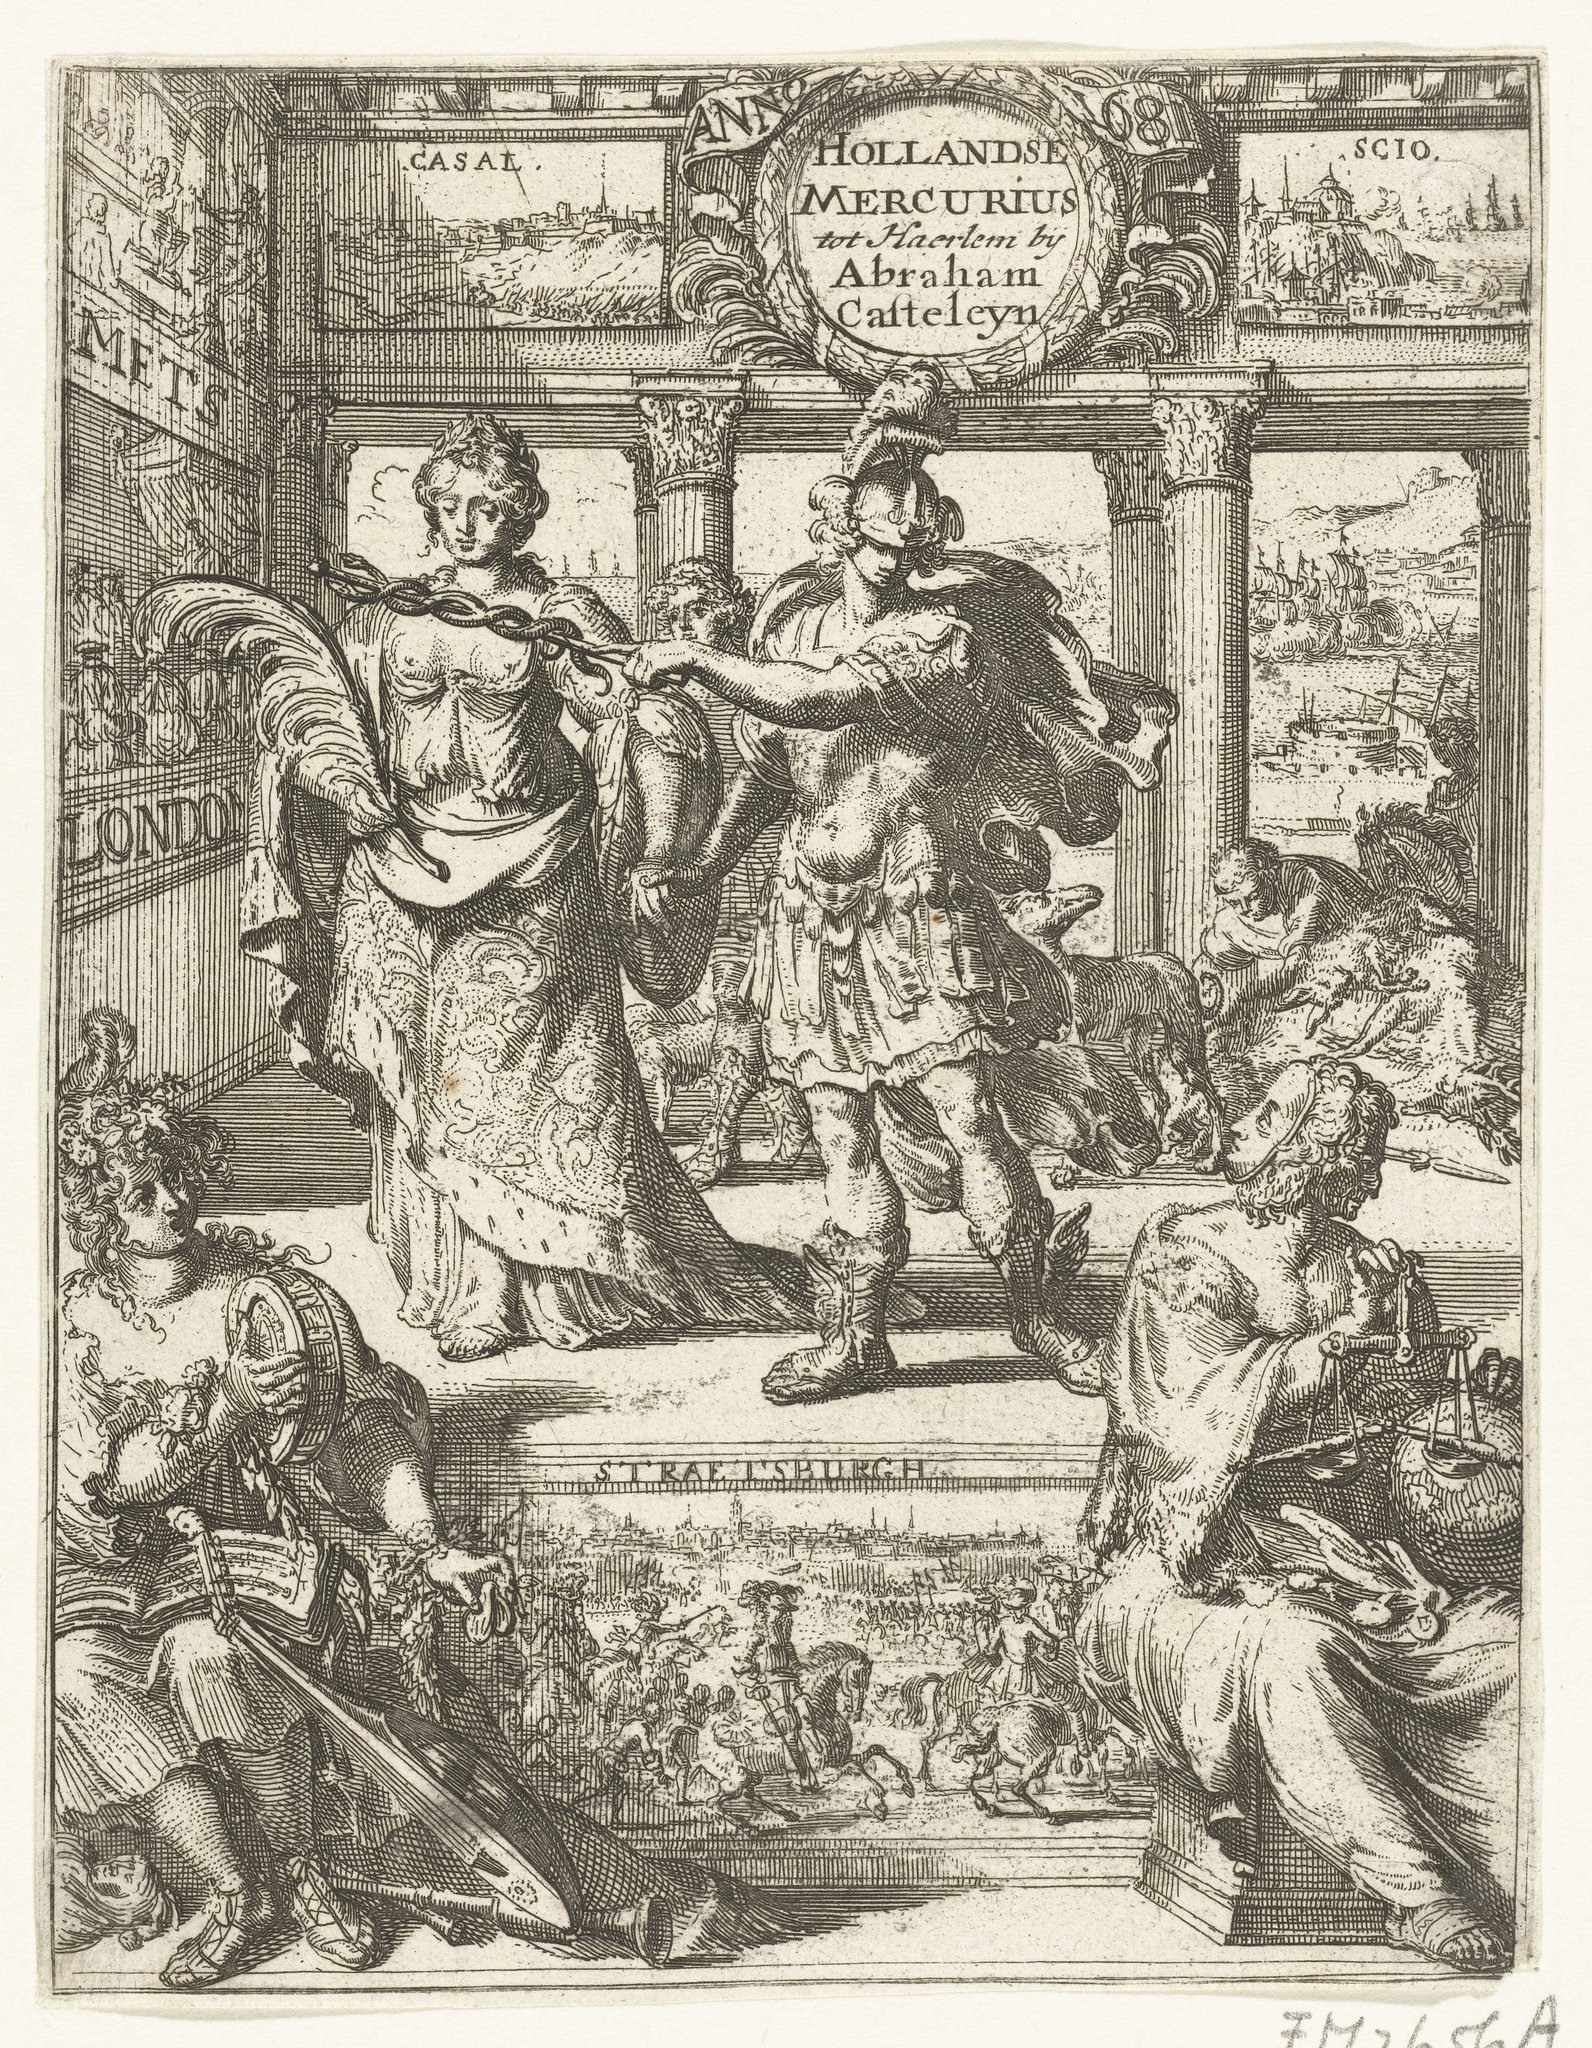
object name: titelblad, titelpagina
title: Titelpagina voor de Hollandsche Mercurius over het jaar 1681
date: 1682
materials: paper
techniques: etching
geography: haarlem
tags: justice, 'justitia'; 'giustitia divina' (ripa) ~ one of the four cardinal virtues, 'musica', symbolic representations, allegories and emblems ~ music; 'musica'(ripa), symbols, allegories of peace, 'pax'; 'pace' (ripa), specific aspects, allegorical aspects of mercury; mercury as patron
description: Titelpagina voor de Hollandsche Mercurius over het jaar 1681. Mercurius en Vrede hand in hand, op de voorgrond Muziek en Rechtvaardigheid.